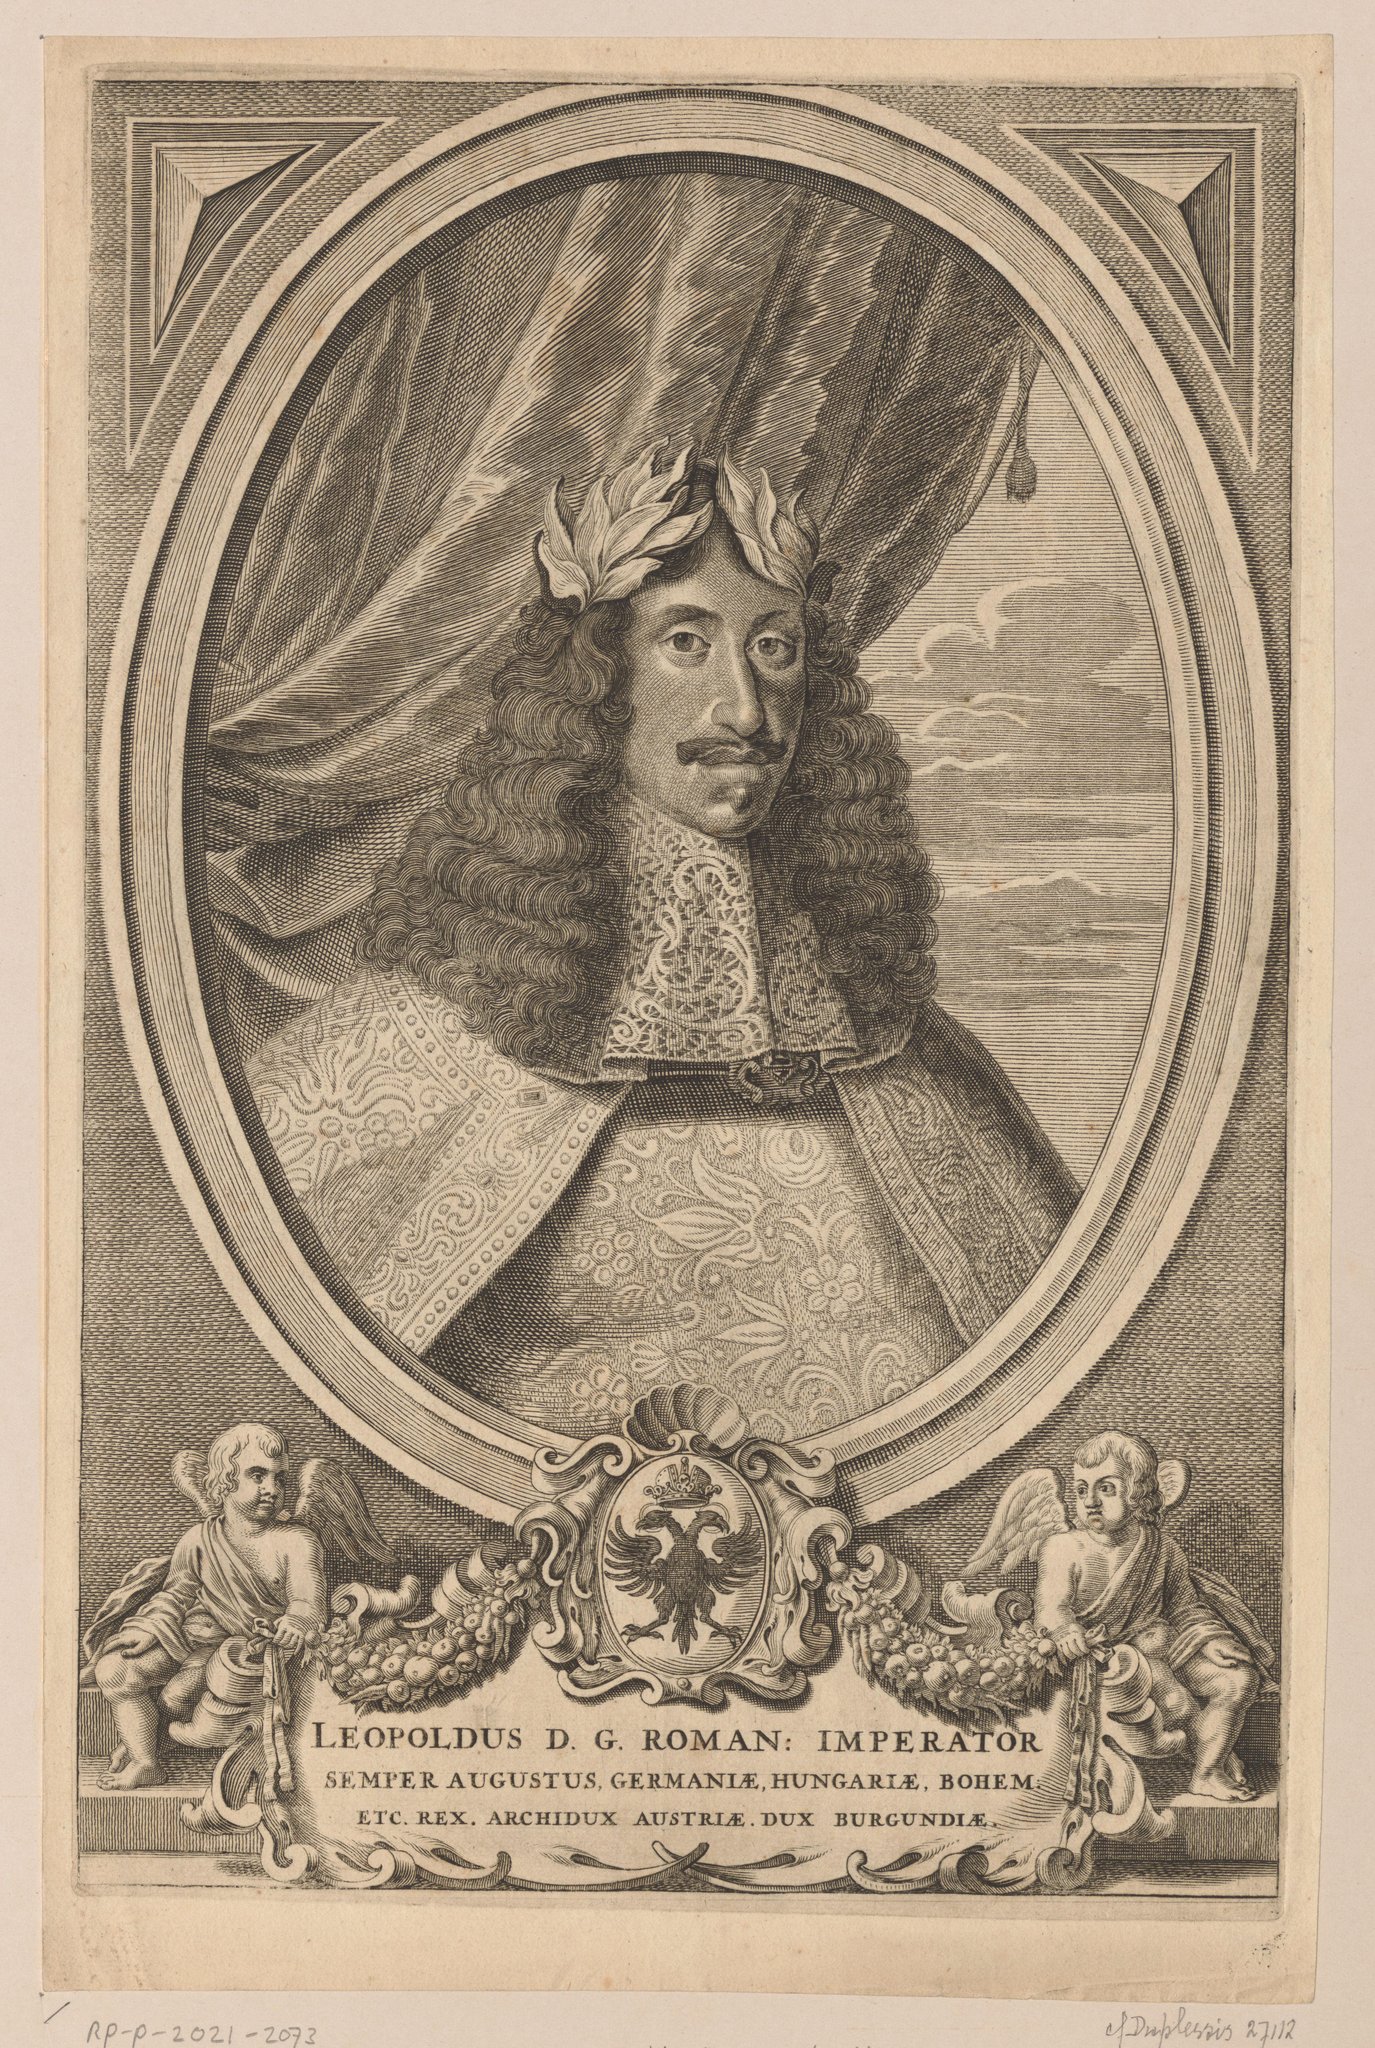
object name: print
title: Portret van keizer Leopold I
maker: Anonymous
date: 1689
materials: paper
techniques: engraving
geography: amsterdam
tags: vienna, leopold i (keizer van duitsland), coat of arms (as symbol of the state, etc.), ornament ~ medallion, historical persons, emperor, scallop, shell ~ ornament, cupids: 'amores', 'amoretti', 'putti'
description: Prent waarschijnlijk uit: Leti, Gregorio. Ritratti Historici, o vero (...). Amsterdam: Gregorio Leti, 1689, dl. 2.